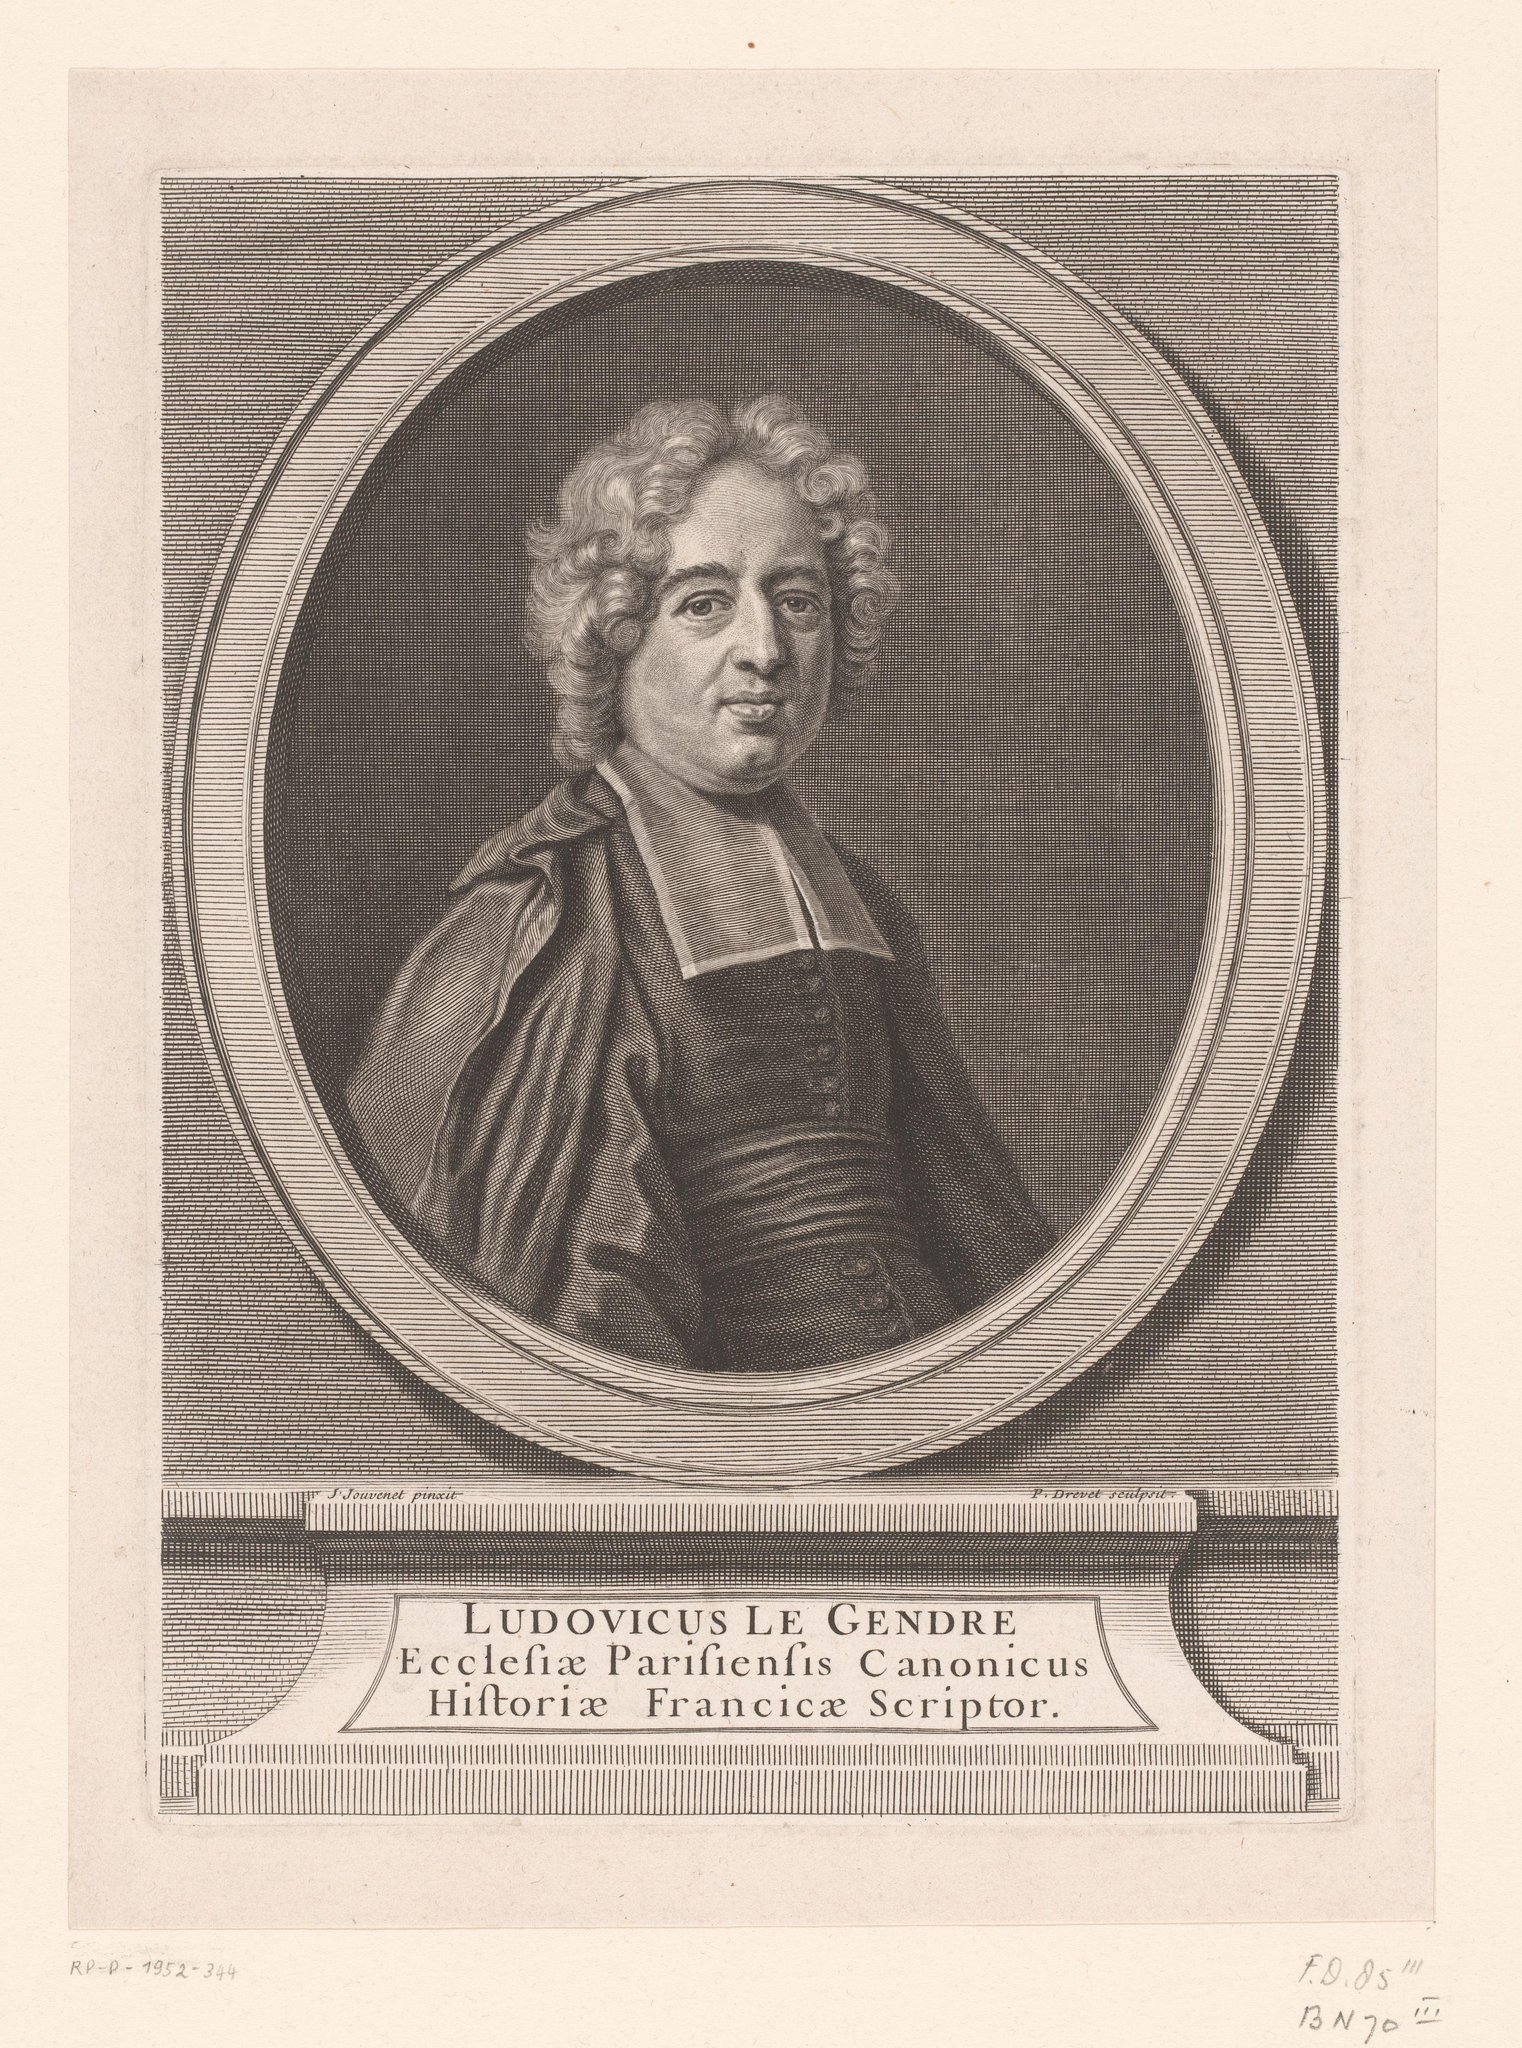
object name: print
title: Portret van Louis Legendre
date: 1673-1738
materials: paper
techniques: engraving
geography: france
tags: painter, louis legendre (1723-1780), ornament ~ medallion, historical persons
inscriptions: collector's mark: Lugt 2228